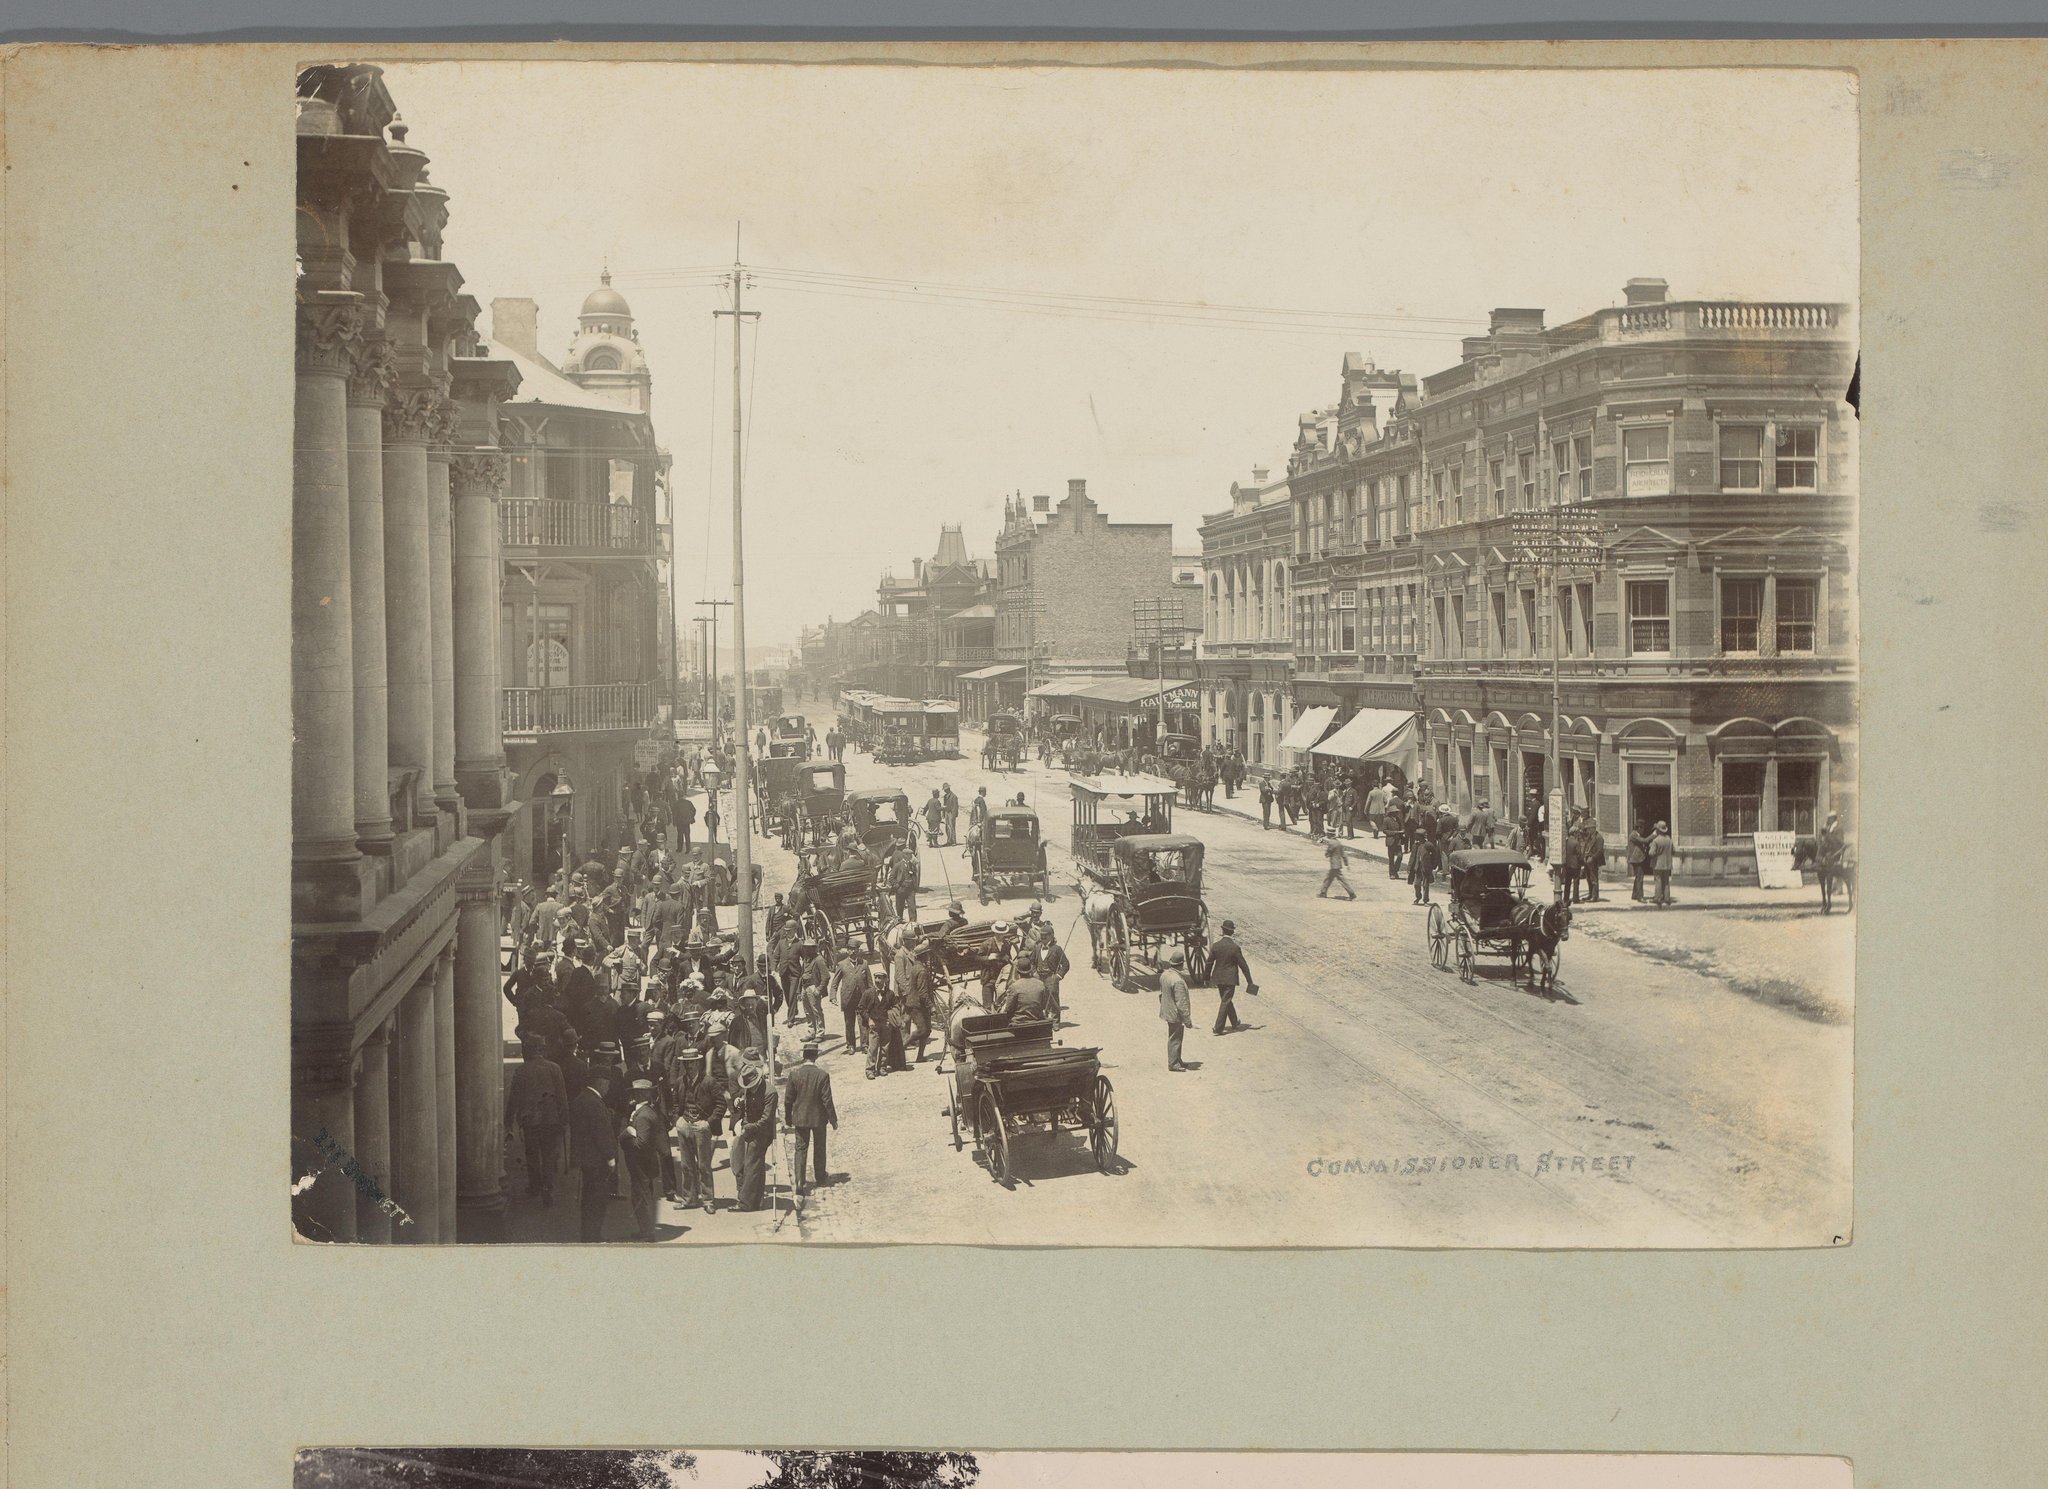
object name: sheet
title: Blad met twee foto's gemaakt in Johannesburg en Pretoria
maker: Anonymous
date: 1890-1905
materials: paper, cardboard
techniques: gelatin silver print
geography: south africa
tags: ceremonial procession, parade, pageant ~ installation of a ruler, street, johannesburg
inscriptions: inscription: ‘uit archief Veen, 1970’, inscription: ‘Zd. Afrika’